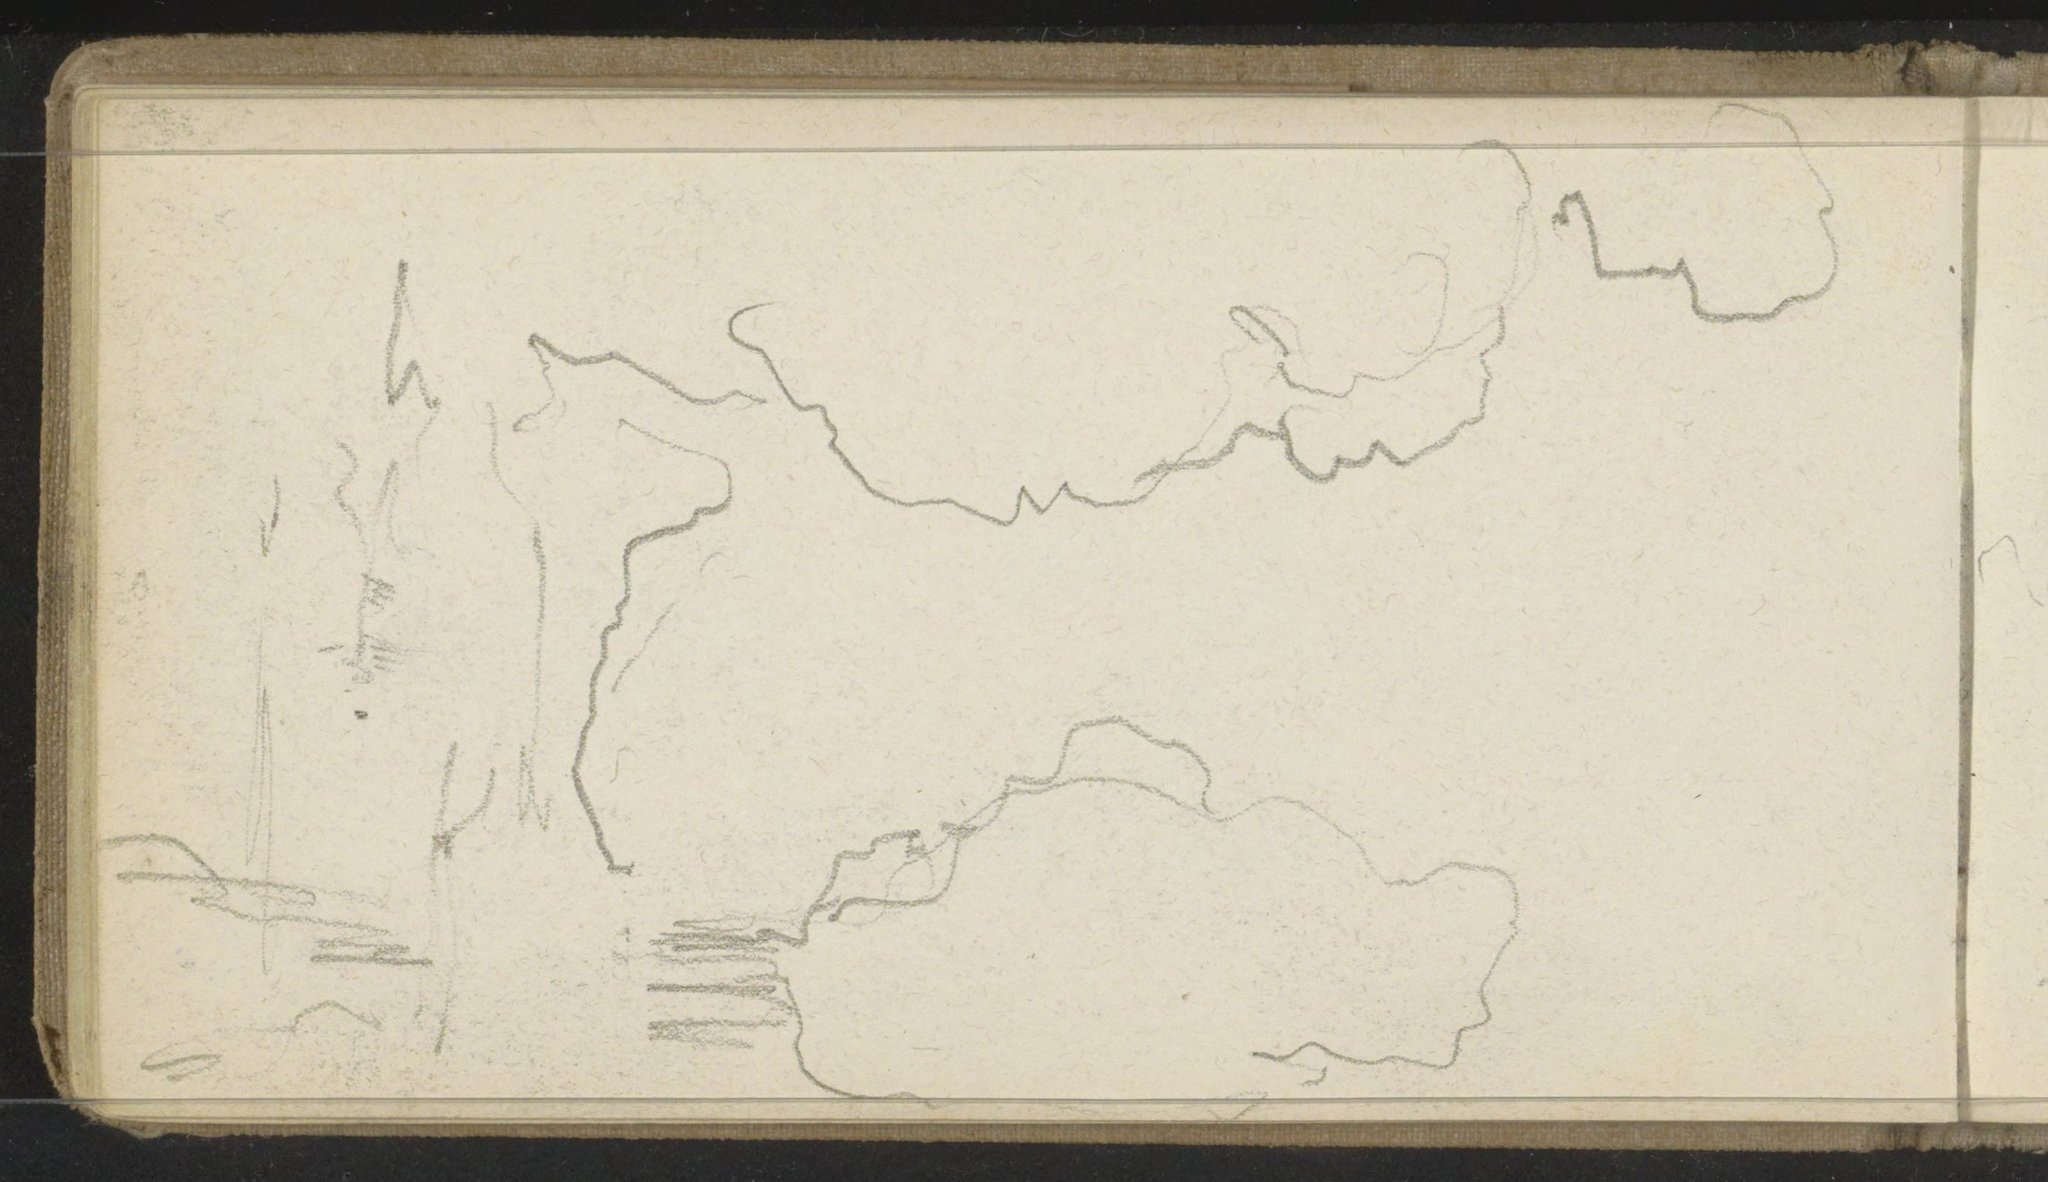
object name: sketchbook leaf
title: Landschap met bomen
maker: willem cornelis rip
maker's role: draughtsman, painter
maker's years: 1856-1922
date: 1895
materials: paper, pencil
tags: landscapes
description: Blad 21 verso uit een schetsboek met 39 bladen.